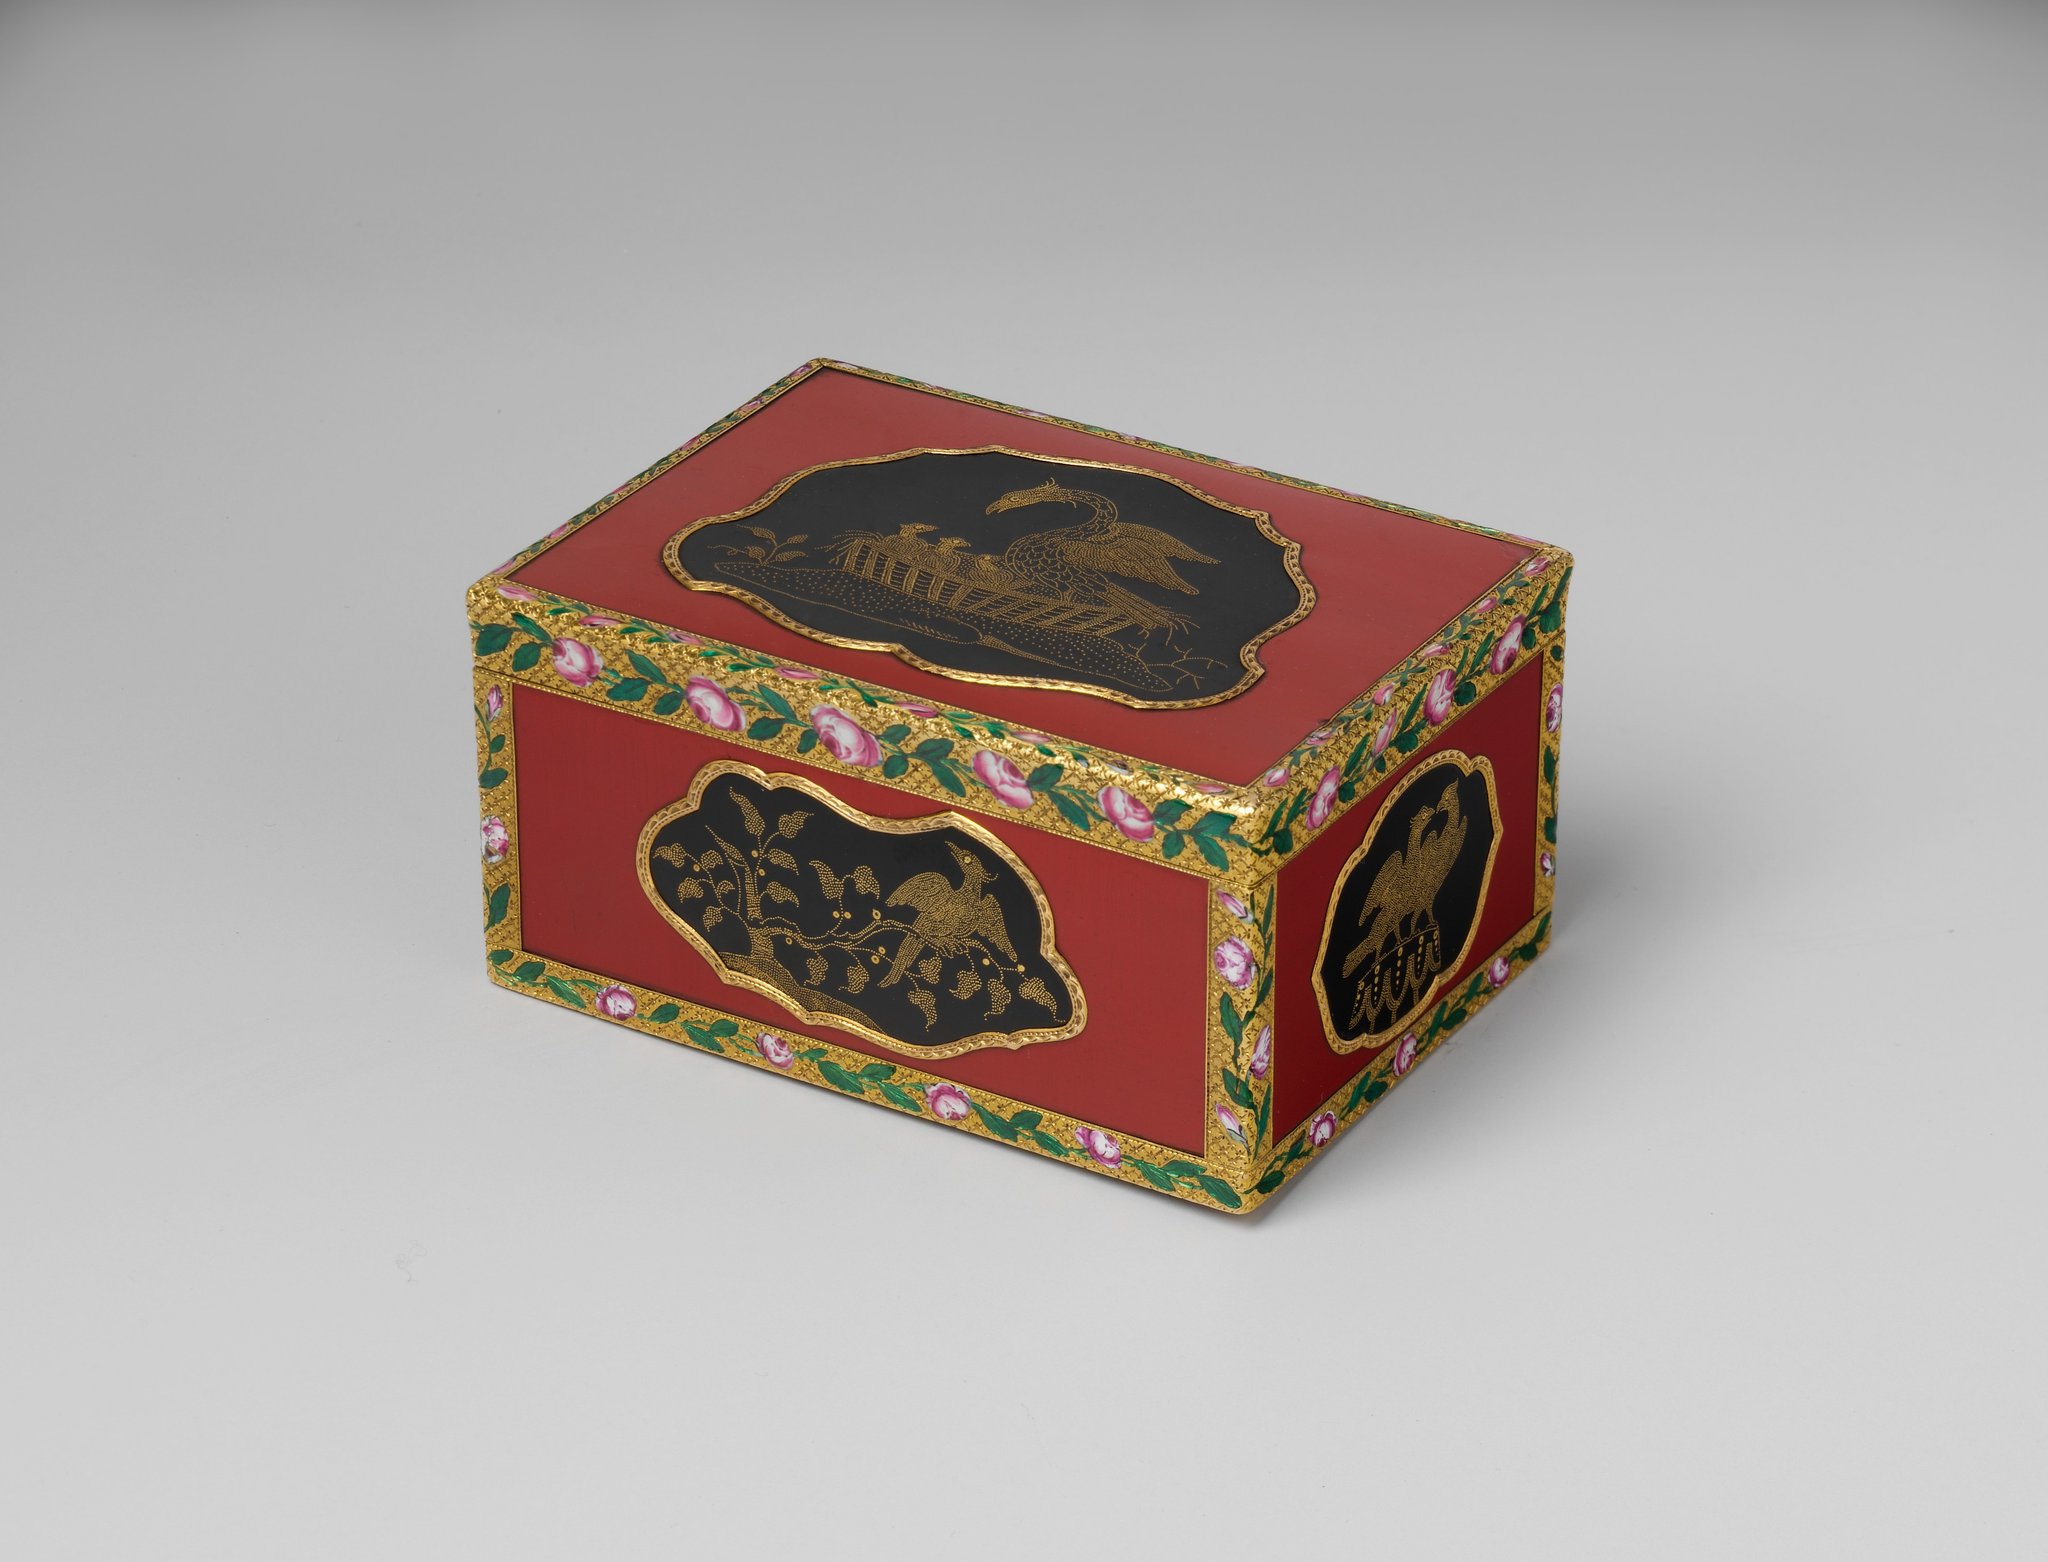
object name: snuffbox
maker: jean ducrollay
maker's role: maker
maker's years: 1709-1760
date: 1754-1755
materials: enamel, gold, shell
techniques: inlay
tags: birds,trees